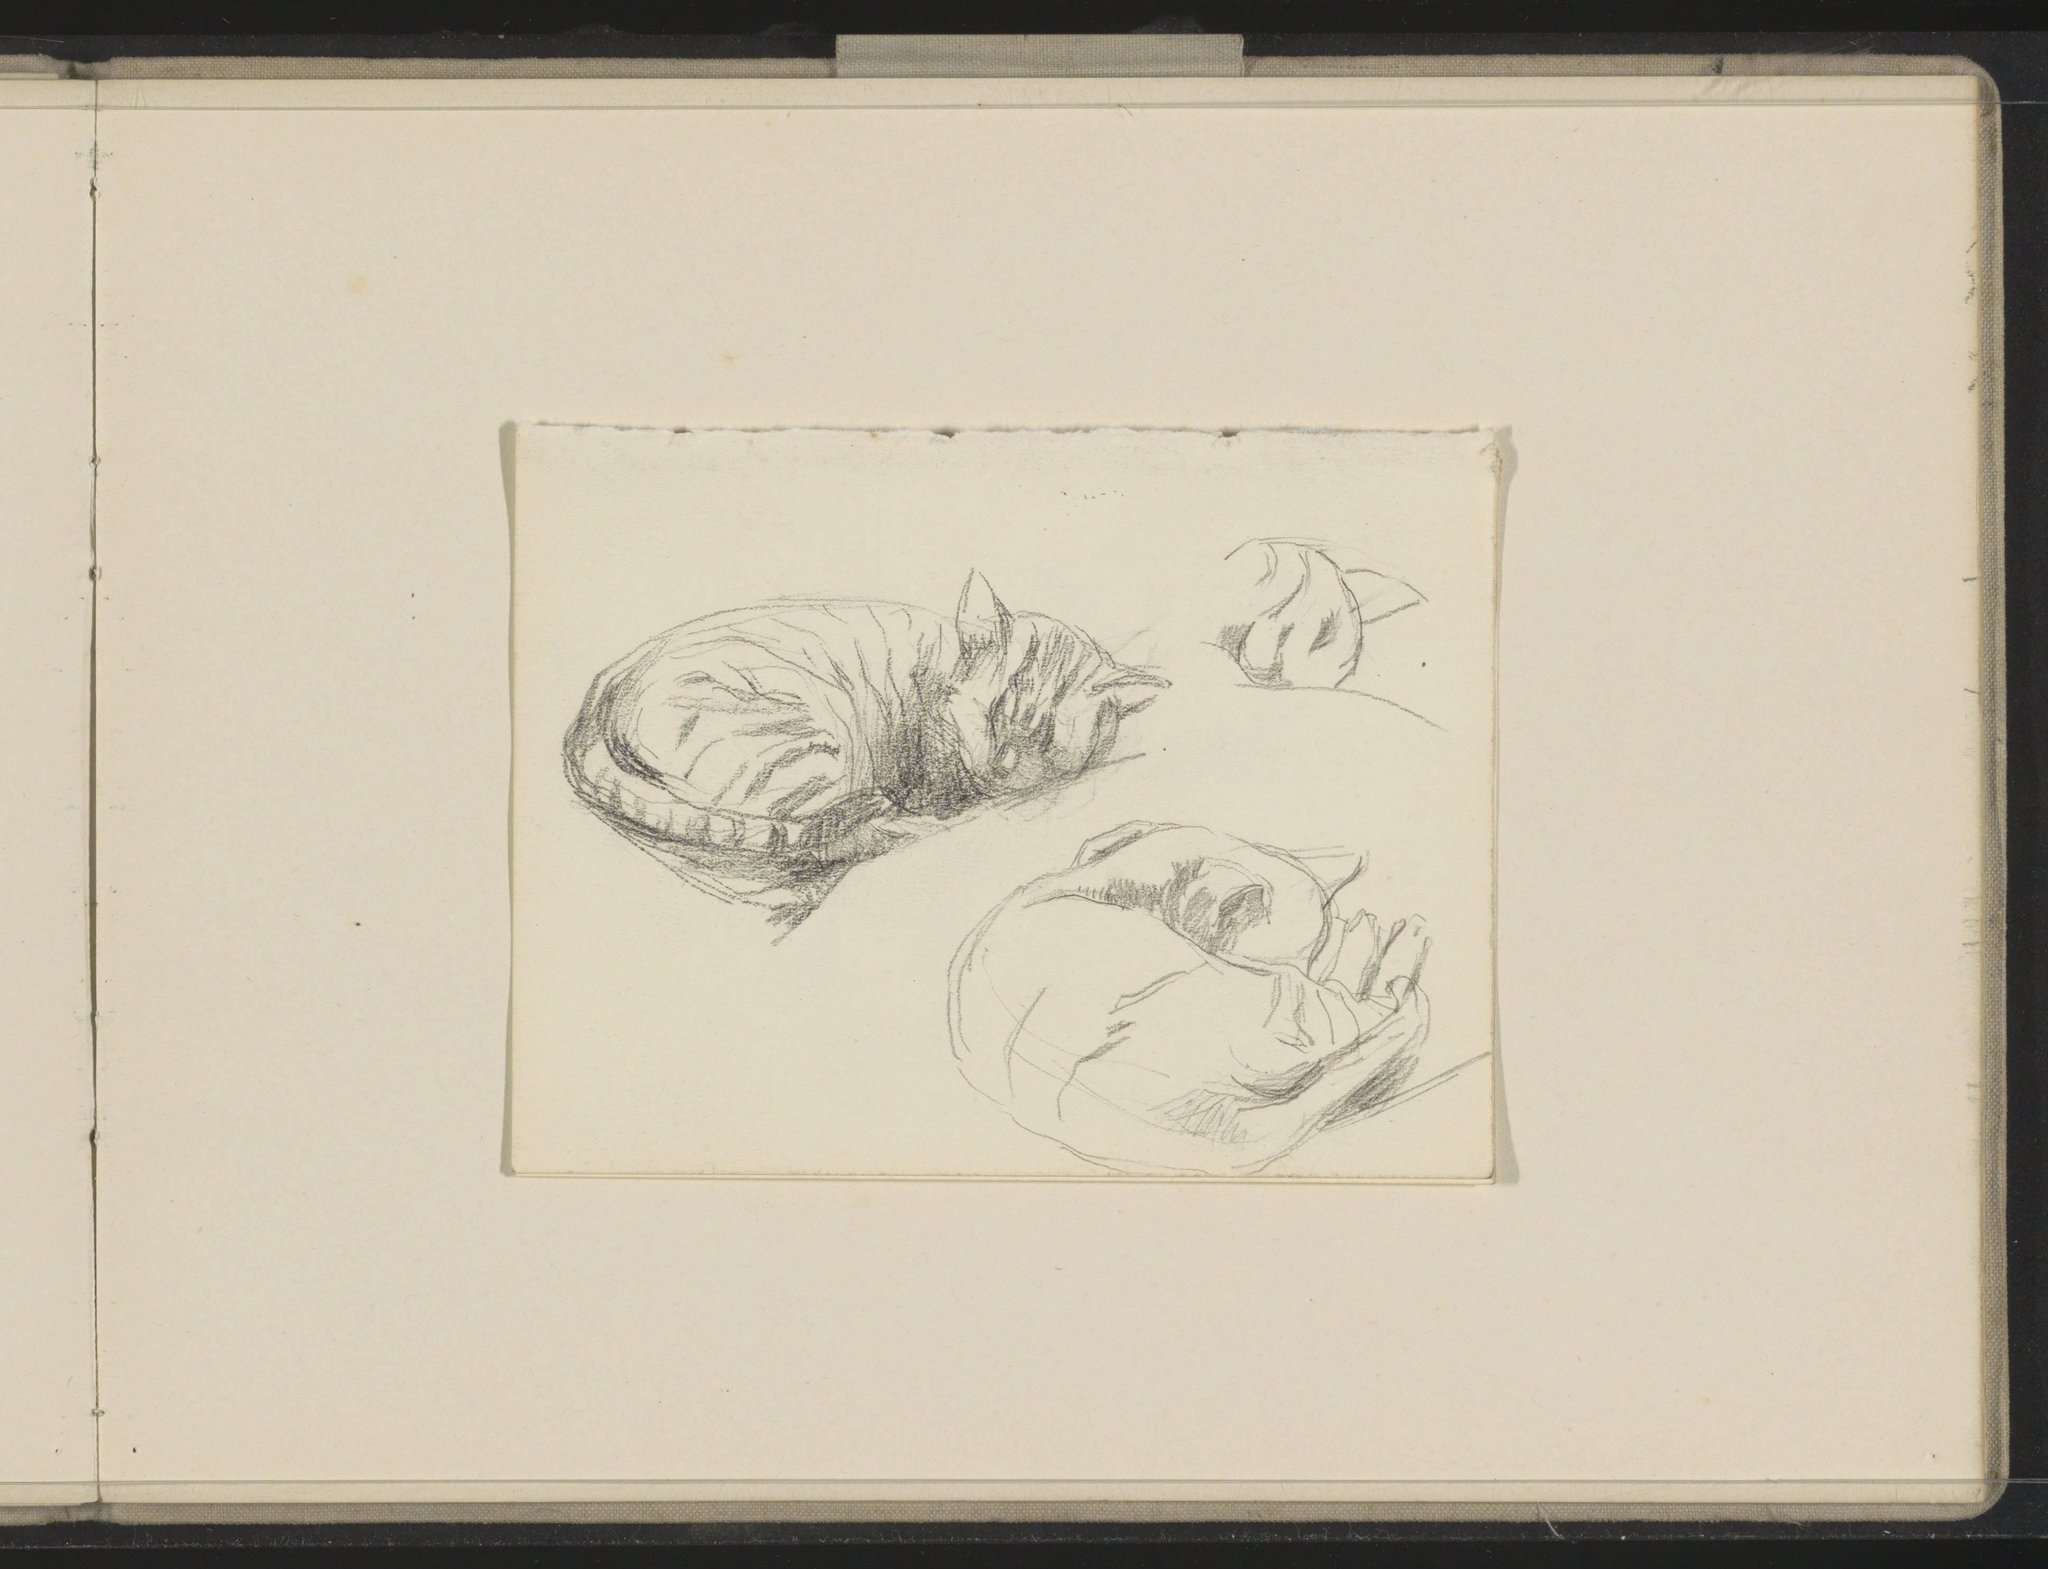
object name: sketchbook leaf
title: Slapende katten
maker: ferdinand oldewelt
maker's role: draughtsman, print maker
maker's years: 1857-1935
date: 1908-1923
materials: chalk, paper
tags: cat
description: Los blad tussen blad 27 en 28 uit een schetsboek met 35 bladen.